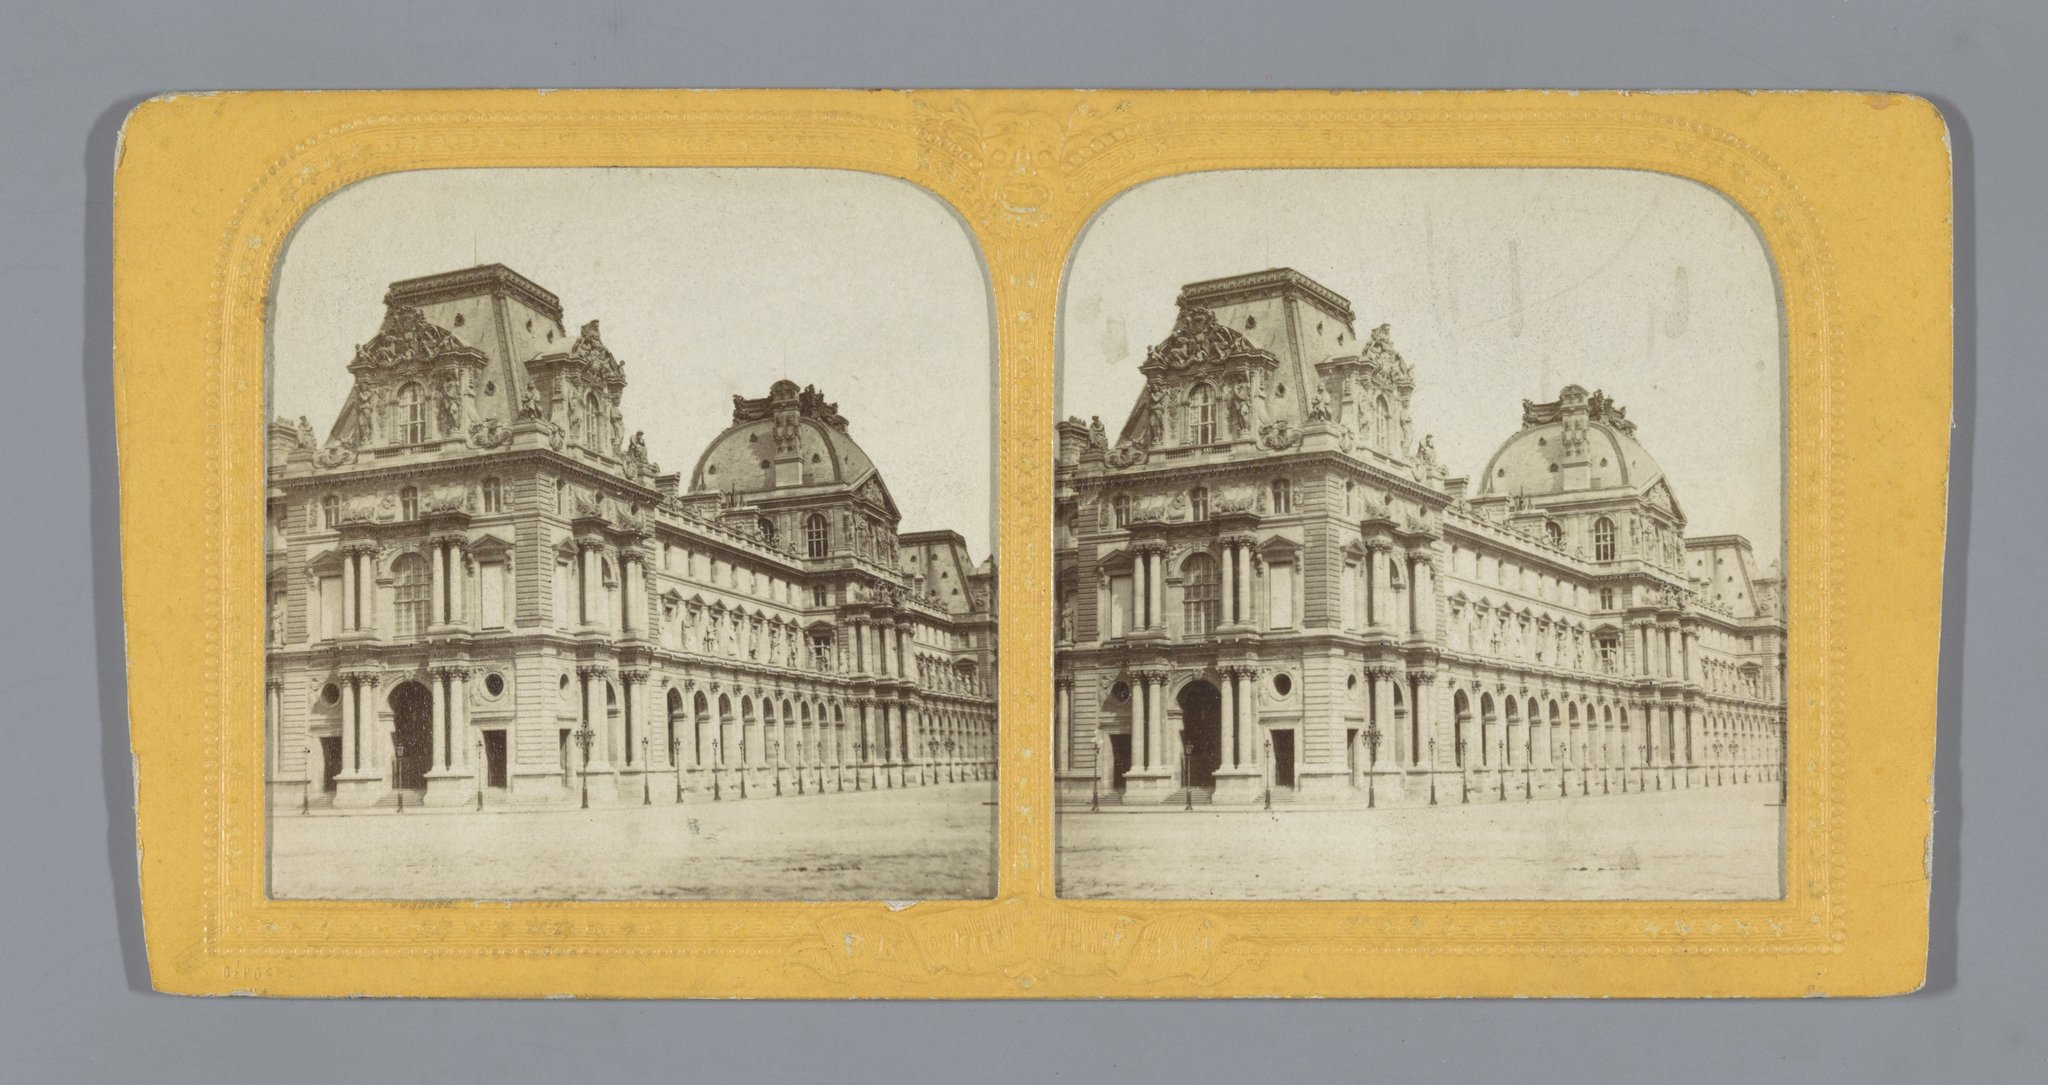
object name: tissue stereograph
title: Le Louvre, Paris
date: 1863-1875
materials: cardboard, paper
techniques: albumen print, hand coloring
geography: paris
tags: palace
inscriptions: inscription: ‘Déposé’